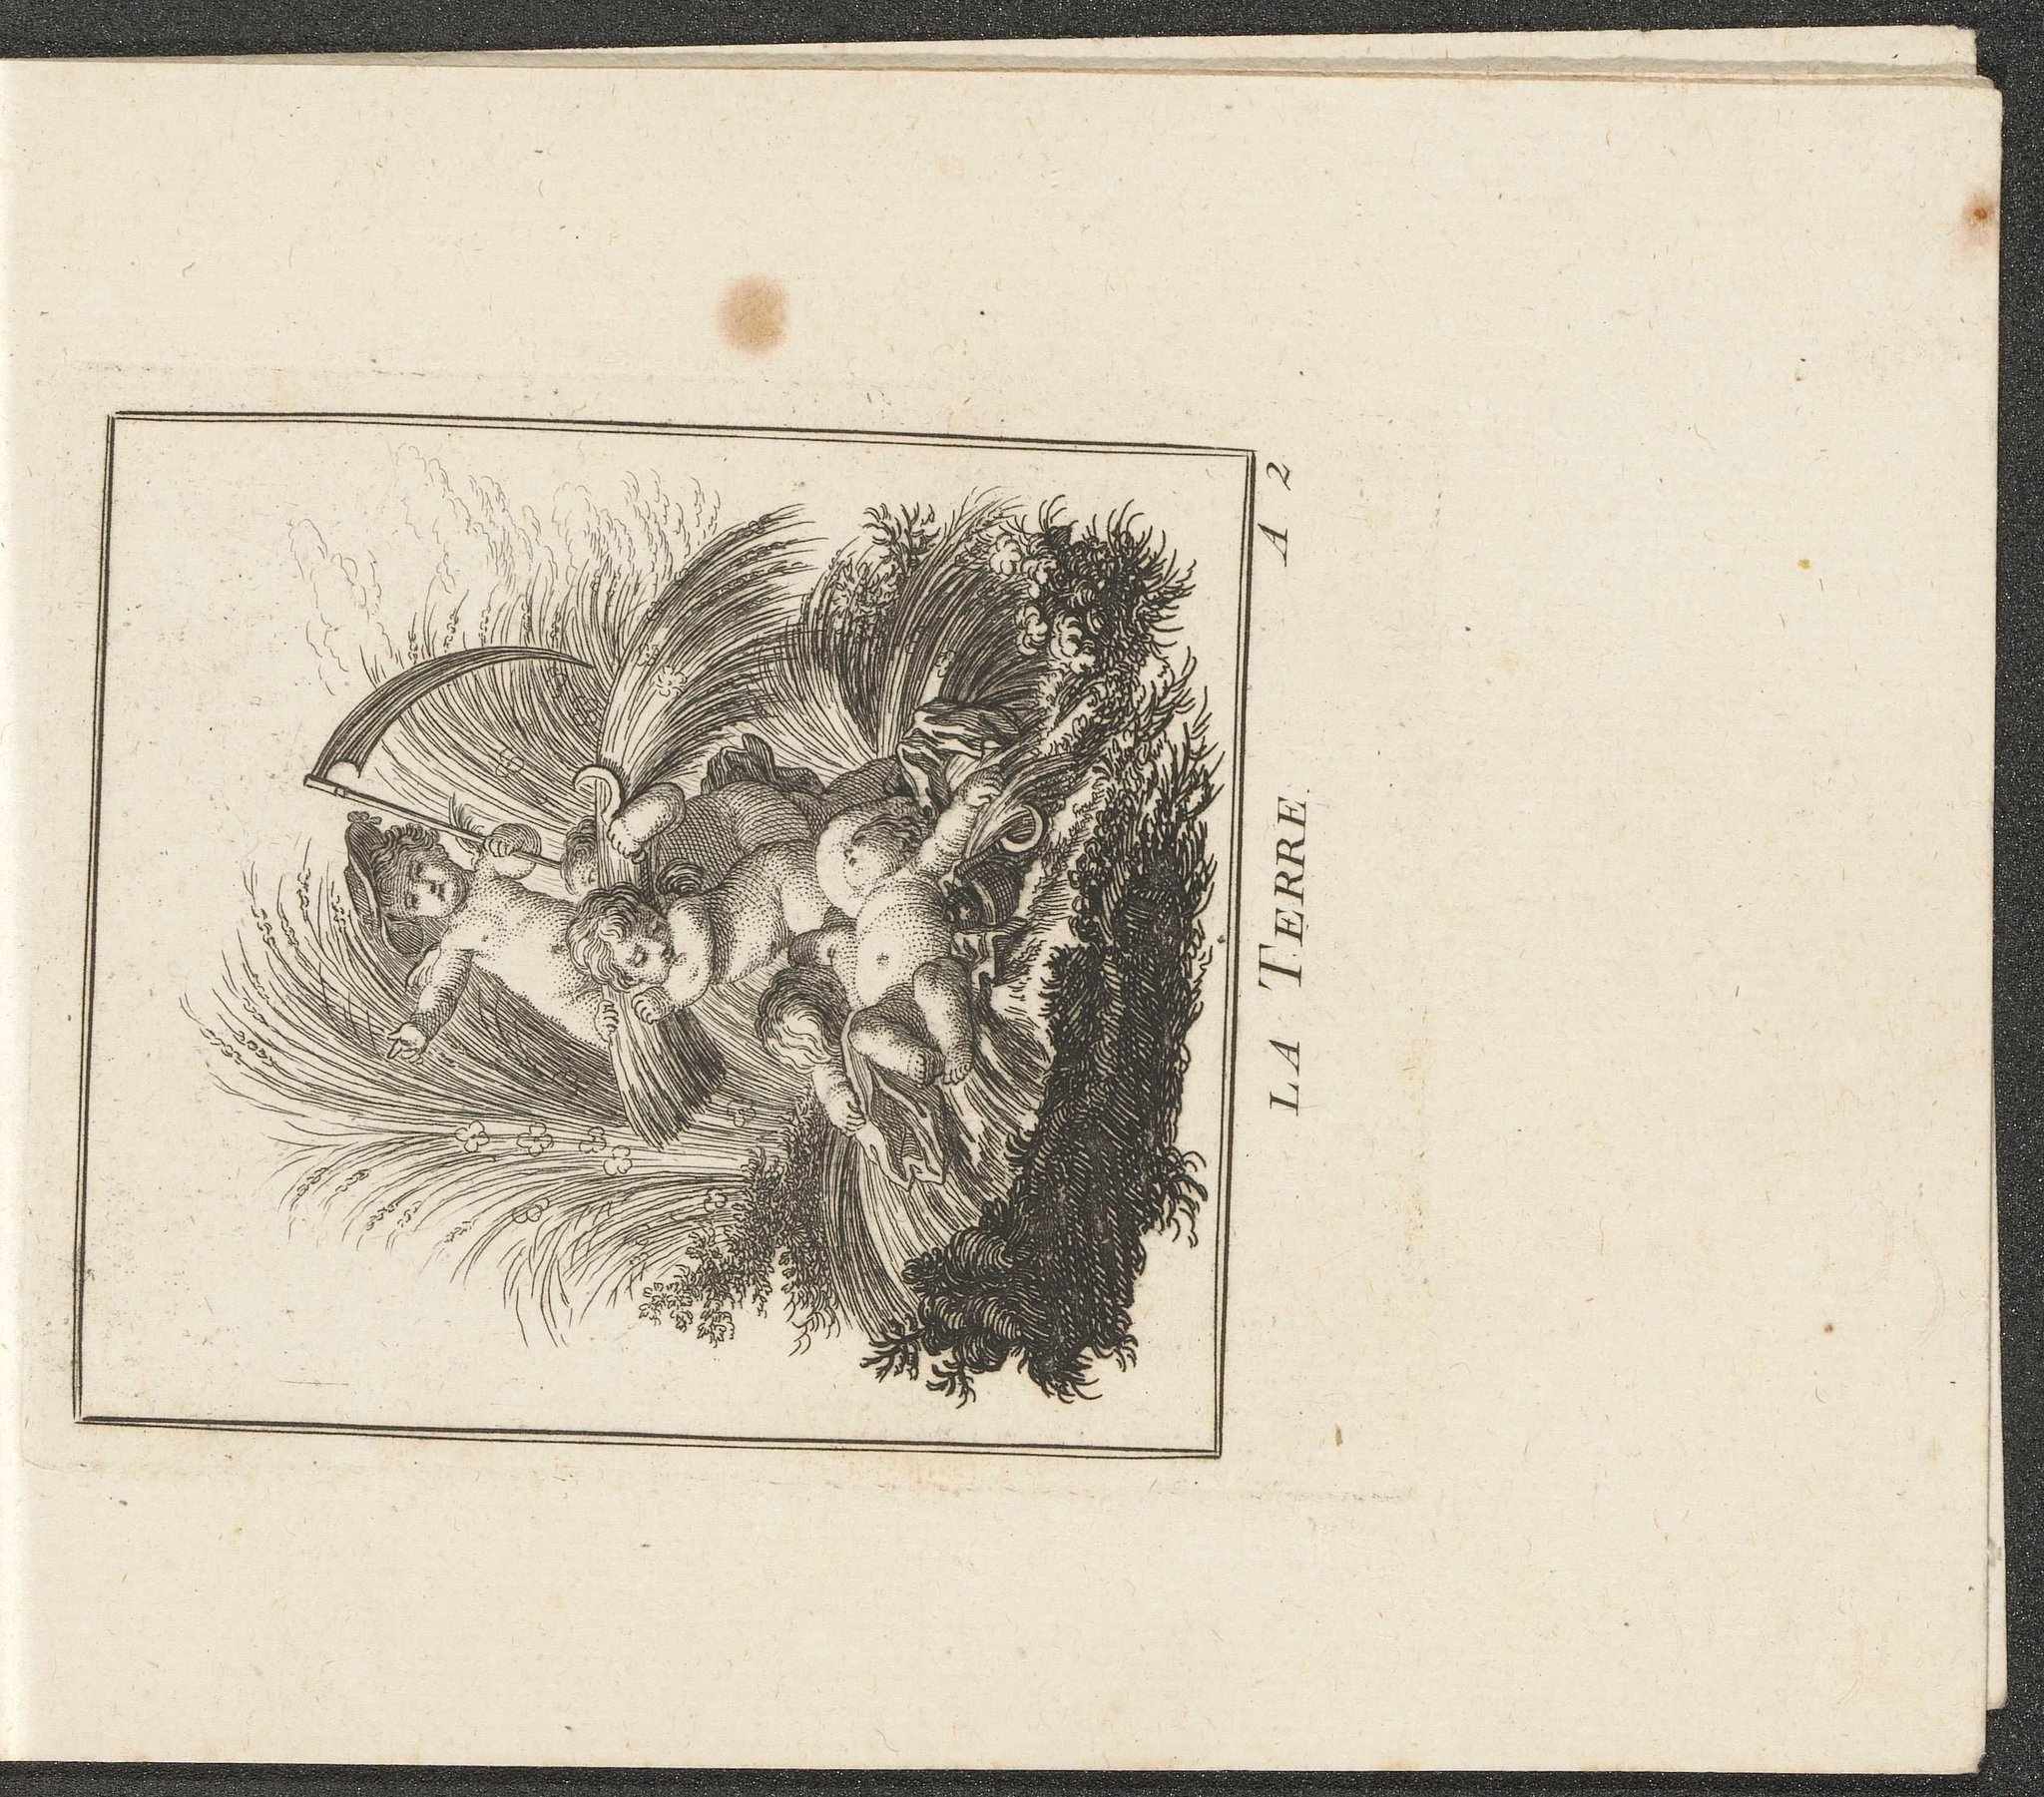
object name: print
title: Vier elementen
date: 1700-1799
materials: paper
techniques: engraving, etching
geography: paris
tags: earth (one of the four elements), cupids: 'amores', 'amoretti', 'putti'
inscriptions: collector's mark: Lugt 2228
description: Drie putti snijden koren met zeis en sikkel, twee putti voor hen liggen te slapen. Rechts onder A genummerd.